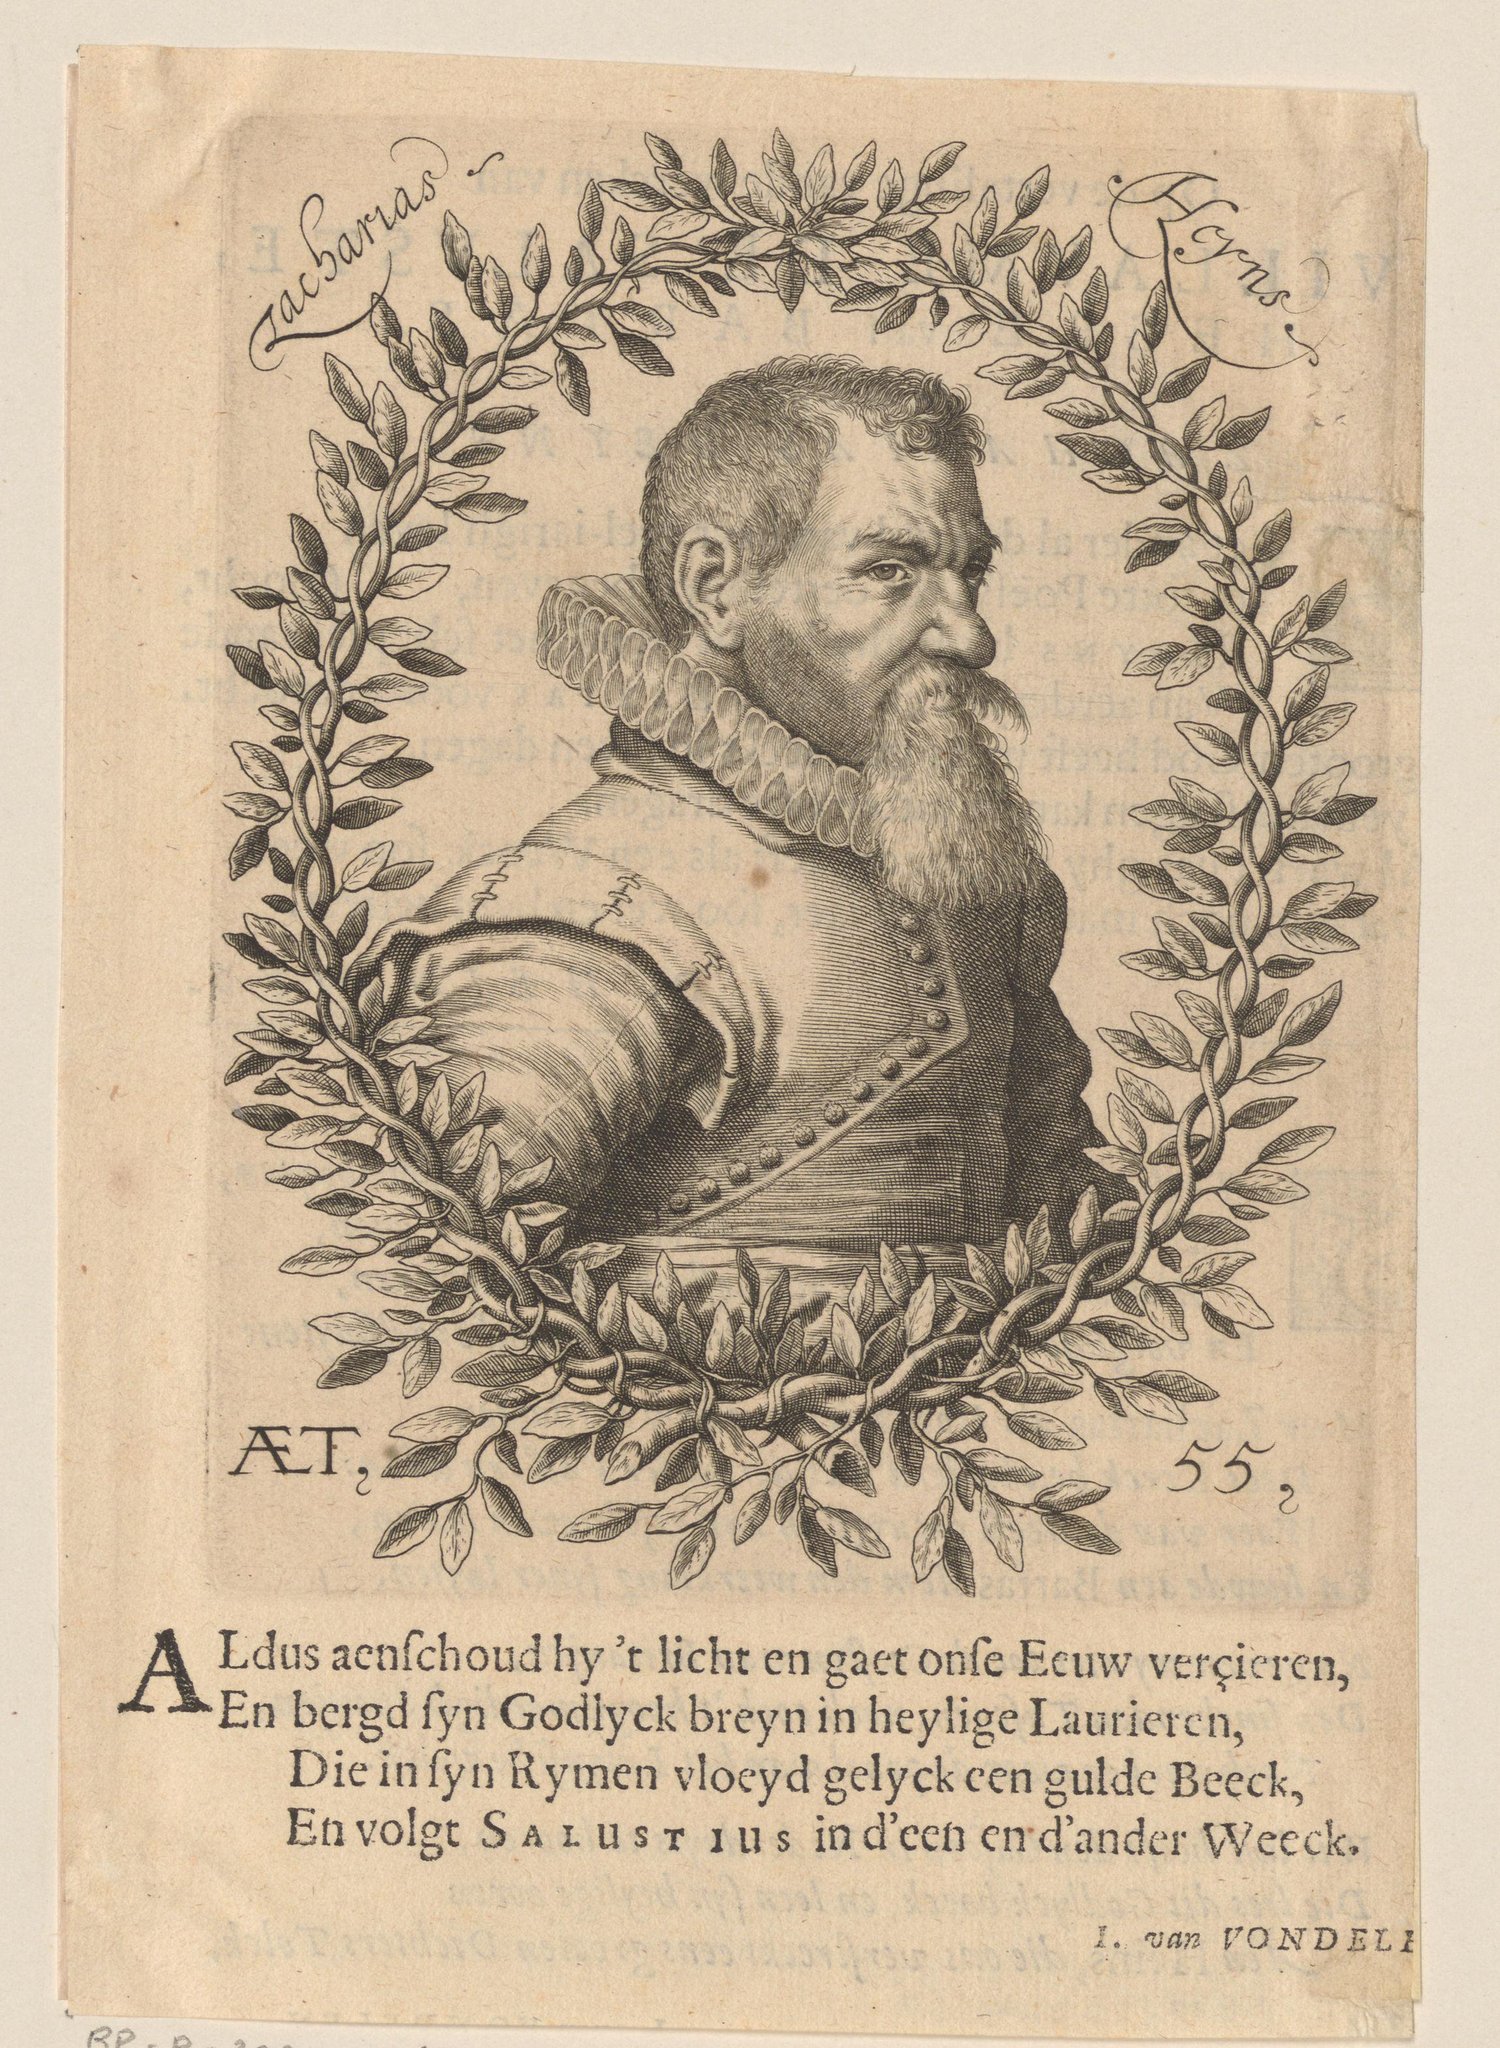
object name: print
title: Portret van Zacharias Heyns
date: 1621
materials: paper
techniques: engraving, letterpress printing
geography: amsterdam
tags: antwerp, print maker, zacharias heyns, historical persons, portrait of a writer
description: Prent uit: Salluste Du Bartas, Guillaume de en Zacharias Heyns. W. S. heere van Bartas wercken. Amsterdam: Paulus Aertsz. van Ravesteijn, 1621.